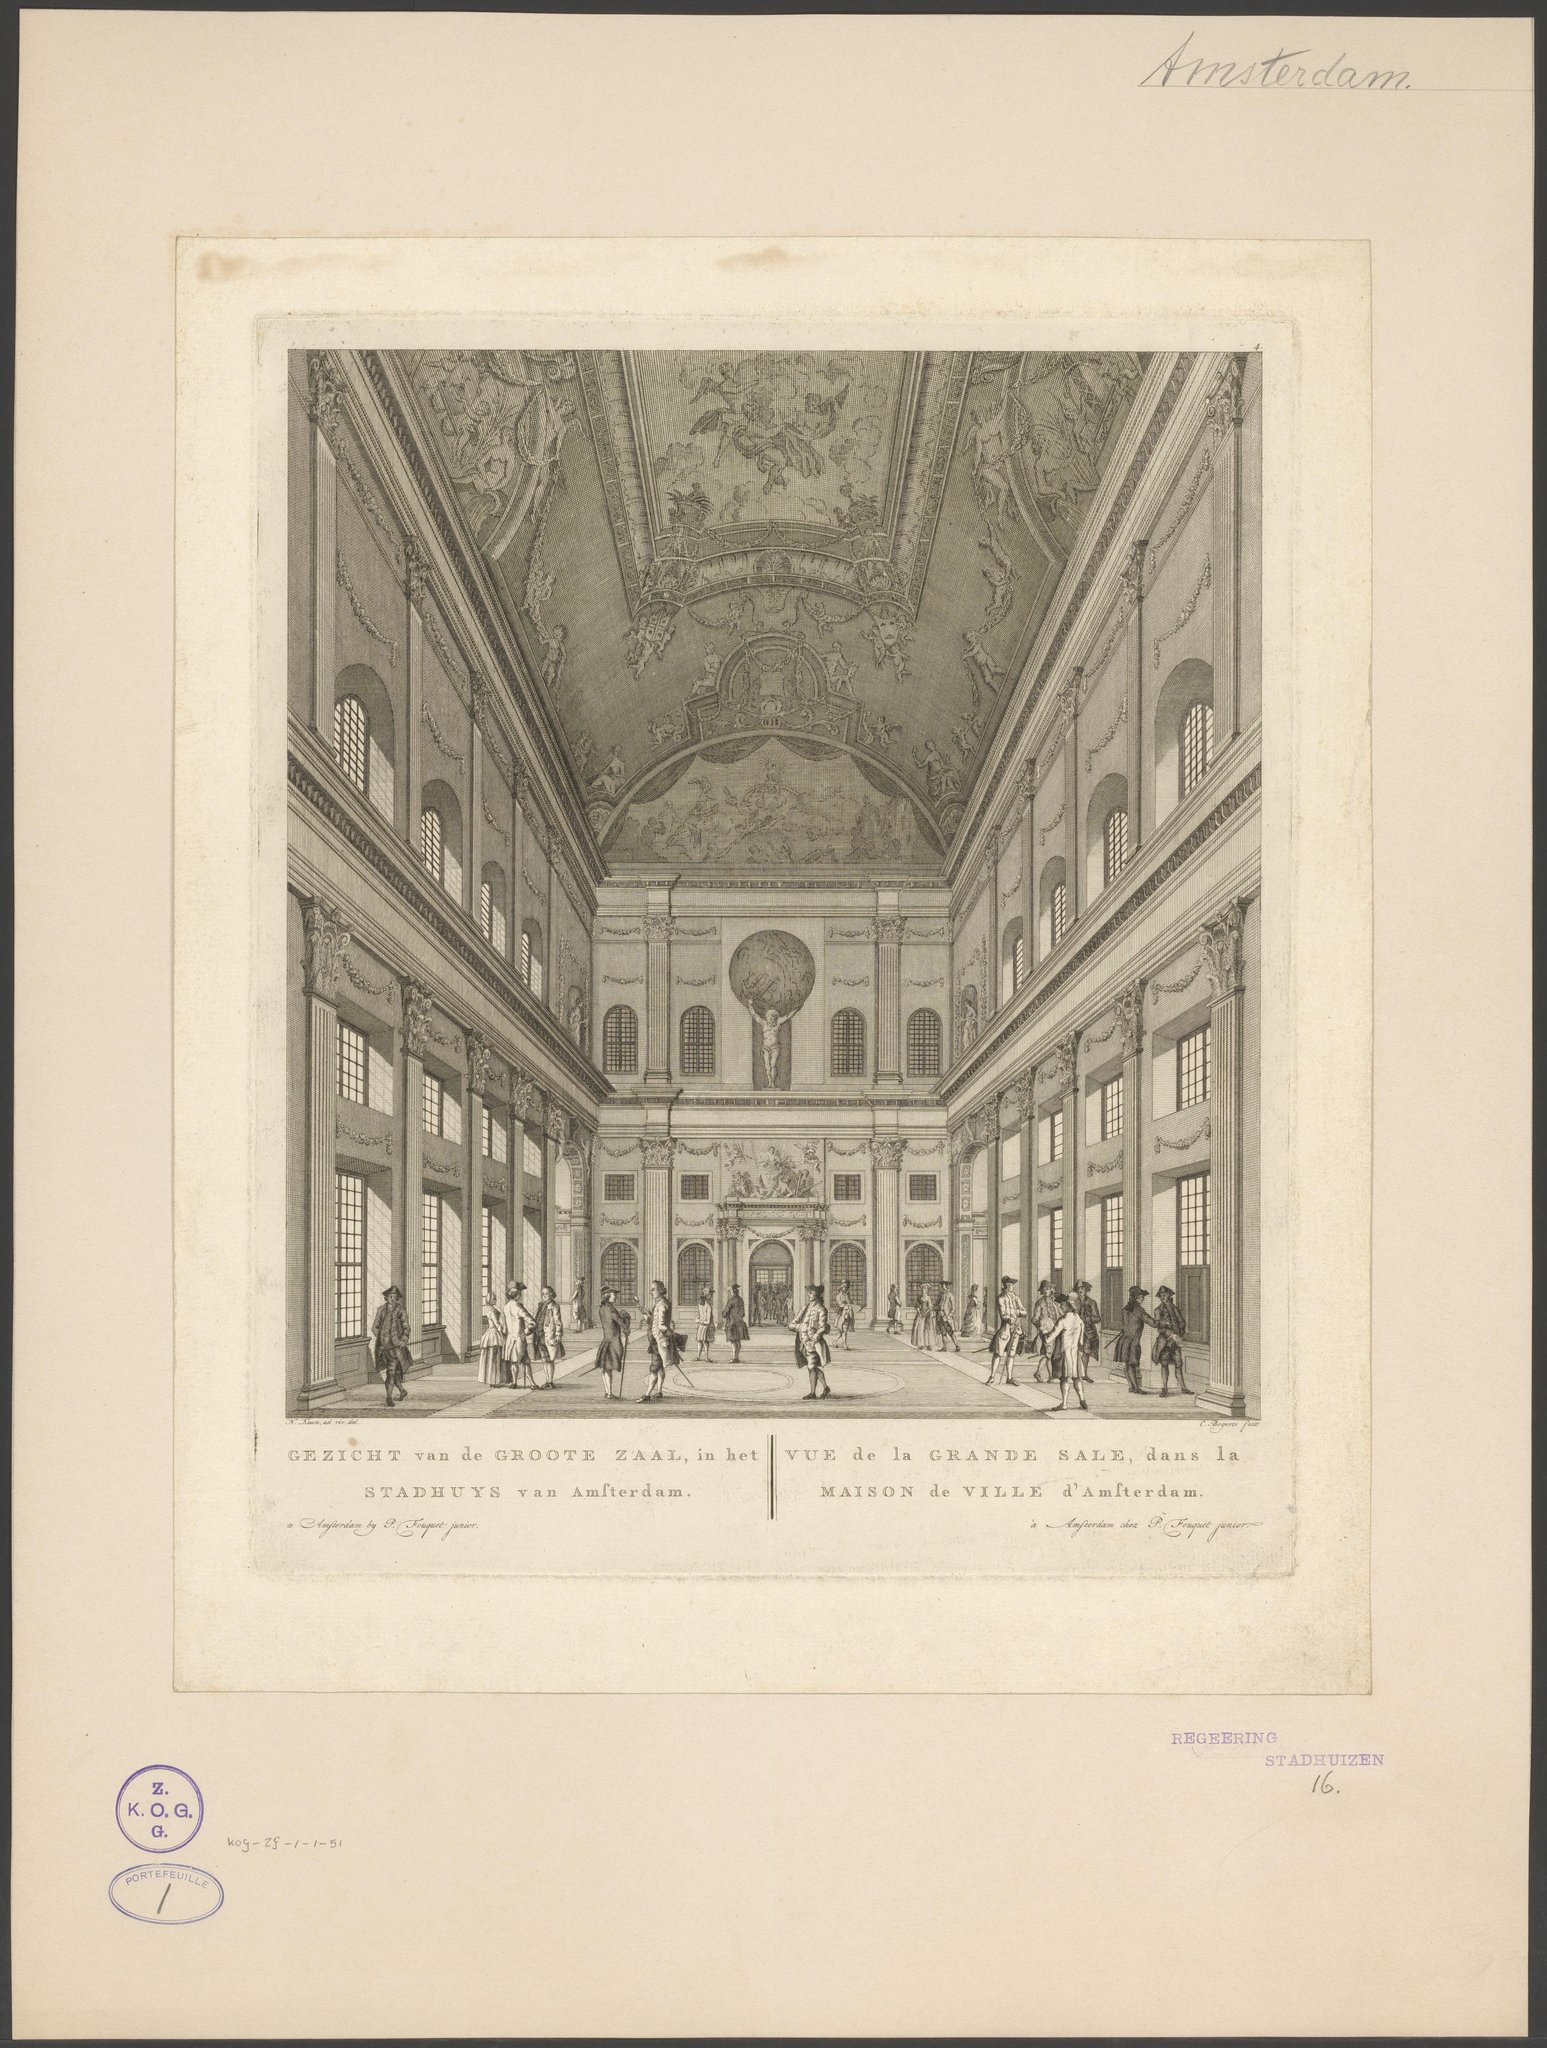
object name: print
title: Westzijde van de Burgerzaal in het Stadhuis op de Dam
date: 1771-1783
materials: paper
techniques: engraving, etching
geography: amsterdam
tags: townhall, interior ~ representation of a building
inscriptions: collector's mark, collector's mark: Lugt 1641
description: Deze prent is ook gebruikt in de zogenaamde Atlas van Fouquet.* Pierre Fouquet gaf vanaf 1760 stadsgezichten van Amsterdam - naar tekeningen van verschillende kunstenaars, gemaakt door verschillende prentmakers - uit. Deze prenten werden aanvankelijk los of in series verkocht. Zoals toen gebruikelijk kon de koper de prenten zelf laten inbinden. Hiertoe gaf Fouquet tussen 1778 en 1783 een titelblad, plattegrond en inhoudsopgave van de tot dusver 100 uitgegeven prenten uit (1). Gezien de inhoud afhankelijk was van wat de koper had verzameld verschilt de inhoud van de verschillende bewaarde Fouquetatlassen onder deze titel sterk. Ook zijn er exemplaren bekend waar tevens andere prenten aan zijn toegevoegd. Omdat er behoefte bleek aan uitleg bij de platen werd in 1783 een nieuwe versie van de atlas uitgegeven, aangevuld met tekst en twee prenten. De aangegeven volgorde veranderde maar de platen van de al eerder uitgegeven prenten bleven ongewijzigd. Deze uitgave werd in opdracht van Fouquet gedrukt bij Daniël Jean Changuion en Petrus den Hengst (2). De huidige staat van de prent komt voor in exemplaren van de onder (1) en (2) genoemde werken. (1). Afbeeldingen van de wyd-vermaarde koopstad Amsterdam benevens des zelvs voornaamste gebouwen en gezigten alle naar het leeven getekend / Receuil des edifices les plus considerables et des plus belles vues, de la fameuse ville d'Amsterdam, dessinées d'après nature. Amsterdam: Pierre Fouquet, 1778-1783. (2). Nieuwe atlas, van de voornaamste gebouwen en gezigten der stad Amsterdam, met derzelver beknopte beschryvingen. 2 delen. Amsterdam: Daniël Jean Changuion en Petrus den Hengst [in opdracht van Pierre Fouquet], 1783.